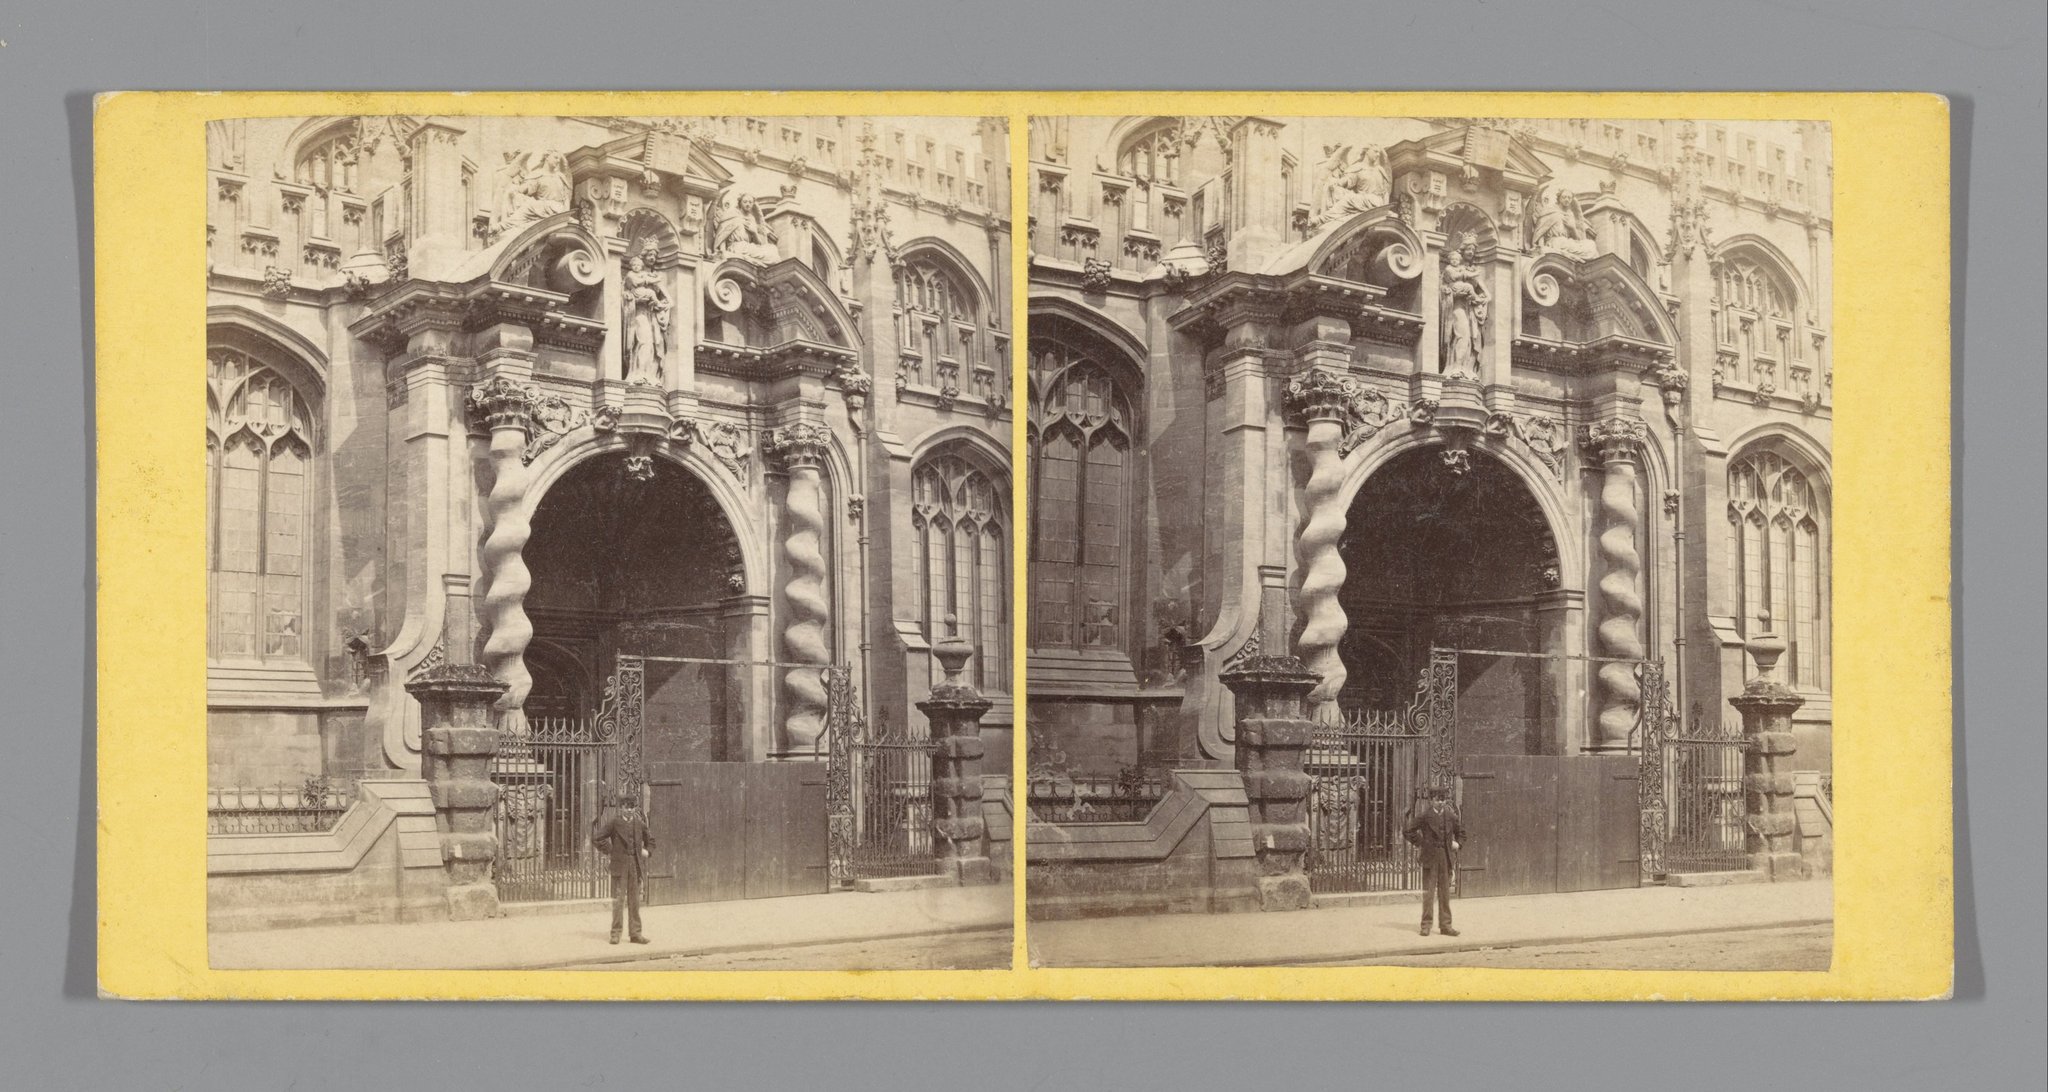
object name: stereograph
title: St. Mary's Church, Oxford The South-West Porch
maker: alexander wilson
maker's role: fotograaf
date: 1850-1880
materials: cardboard, photographic support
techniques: albumen print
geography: oxford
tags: parts of church exterior and annexes: portal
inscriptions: name: ‘William Spreat, Publisher, 229, High Street, Exeter.’, number: ‘No. 207.’